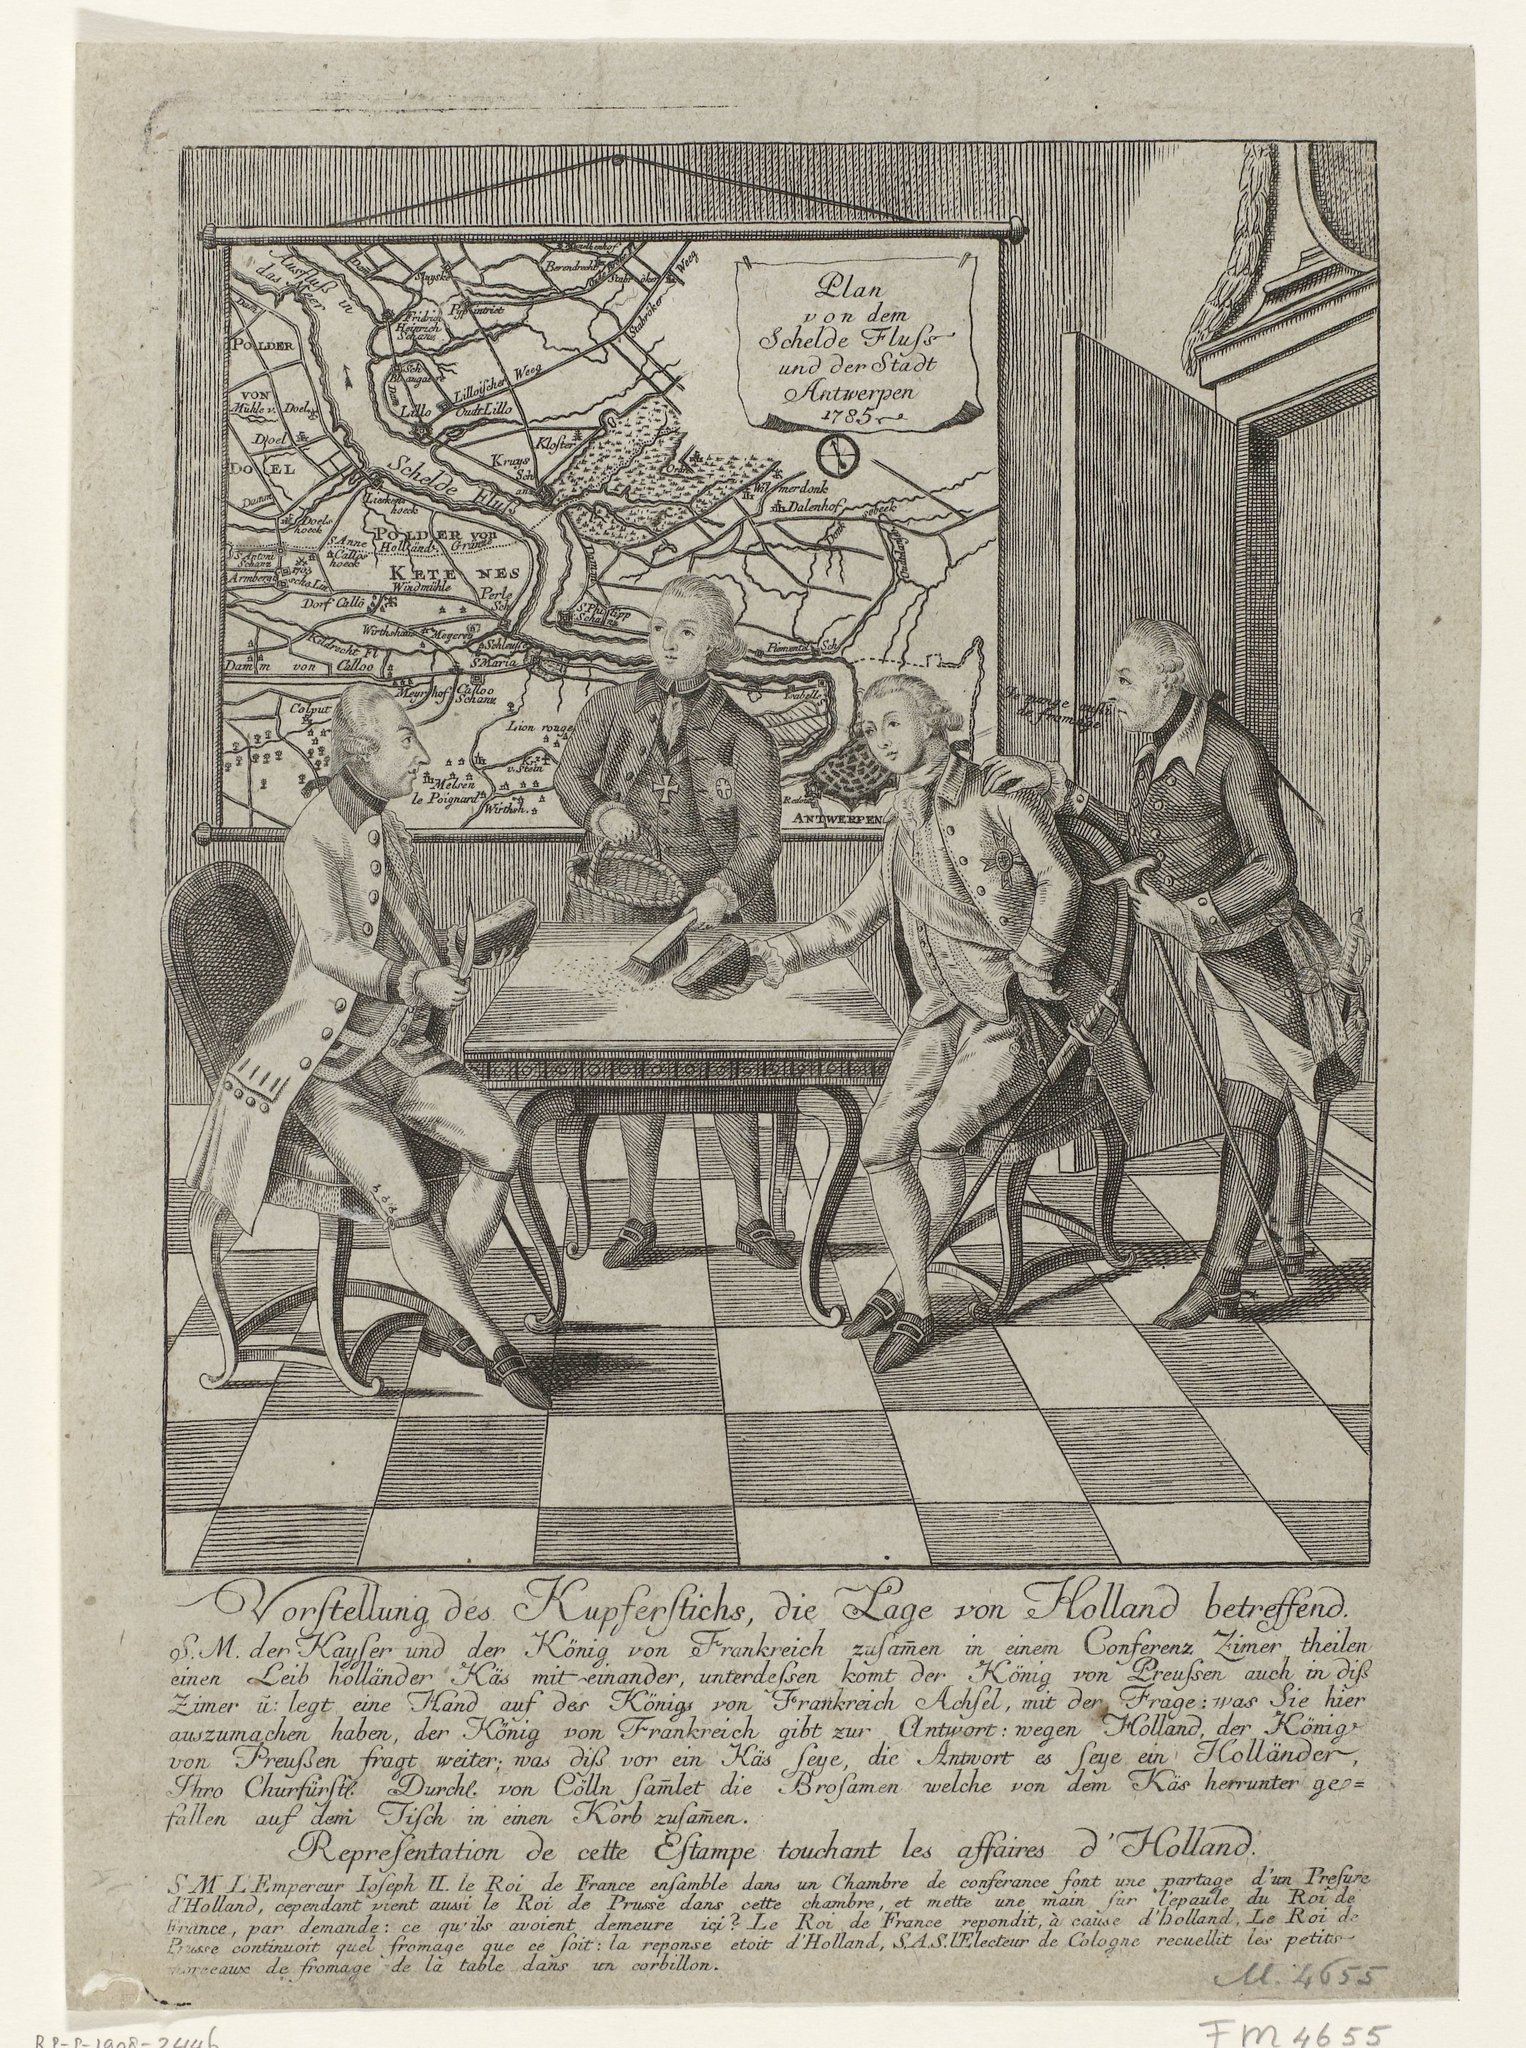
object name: print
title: Spotprent op het Verdrag van Fontainebleau, 1785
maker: Anonymous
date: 1785-1786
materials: paper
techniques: engraving, etching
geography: germany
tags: vienna, jozef ii (duits keizer), frederick ii (king of prussia), lodewijk xvi (koning van frankrijk), cheese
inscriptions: collector's mark: Lugt 2228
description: Spotprent op de vrede gesloten te Parijs waarmee een eind kwam aan de Keteloorlog, de twisten tussen Nederland en de Oostenrijkse keizer Jozef II, 8 november 1785. In een kamer verdelen de Oostenrijkse keizer en de Franse koning Lodewijk XVI een Hollandse kaas. Frederik van Pruisen komt de kamer binnen en wil ook mee-eten van de kaas. De keurvorst van Keulen veegt de kruimels van de tafel. Aan de muur een wandkaart van de Schelde en de stad Antwerpen waar het incident met de keizerlijke brik plaatsvond. In het onderschrift een uitleg van de voorstelling in het Duits en Frans. Op de achterzijde een vage tegendruk van dezelfde voorstelling.